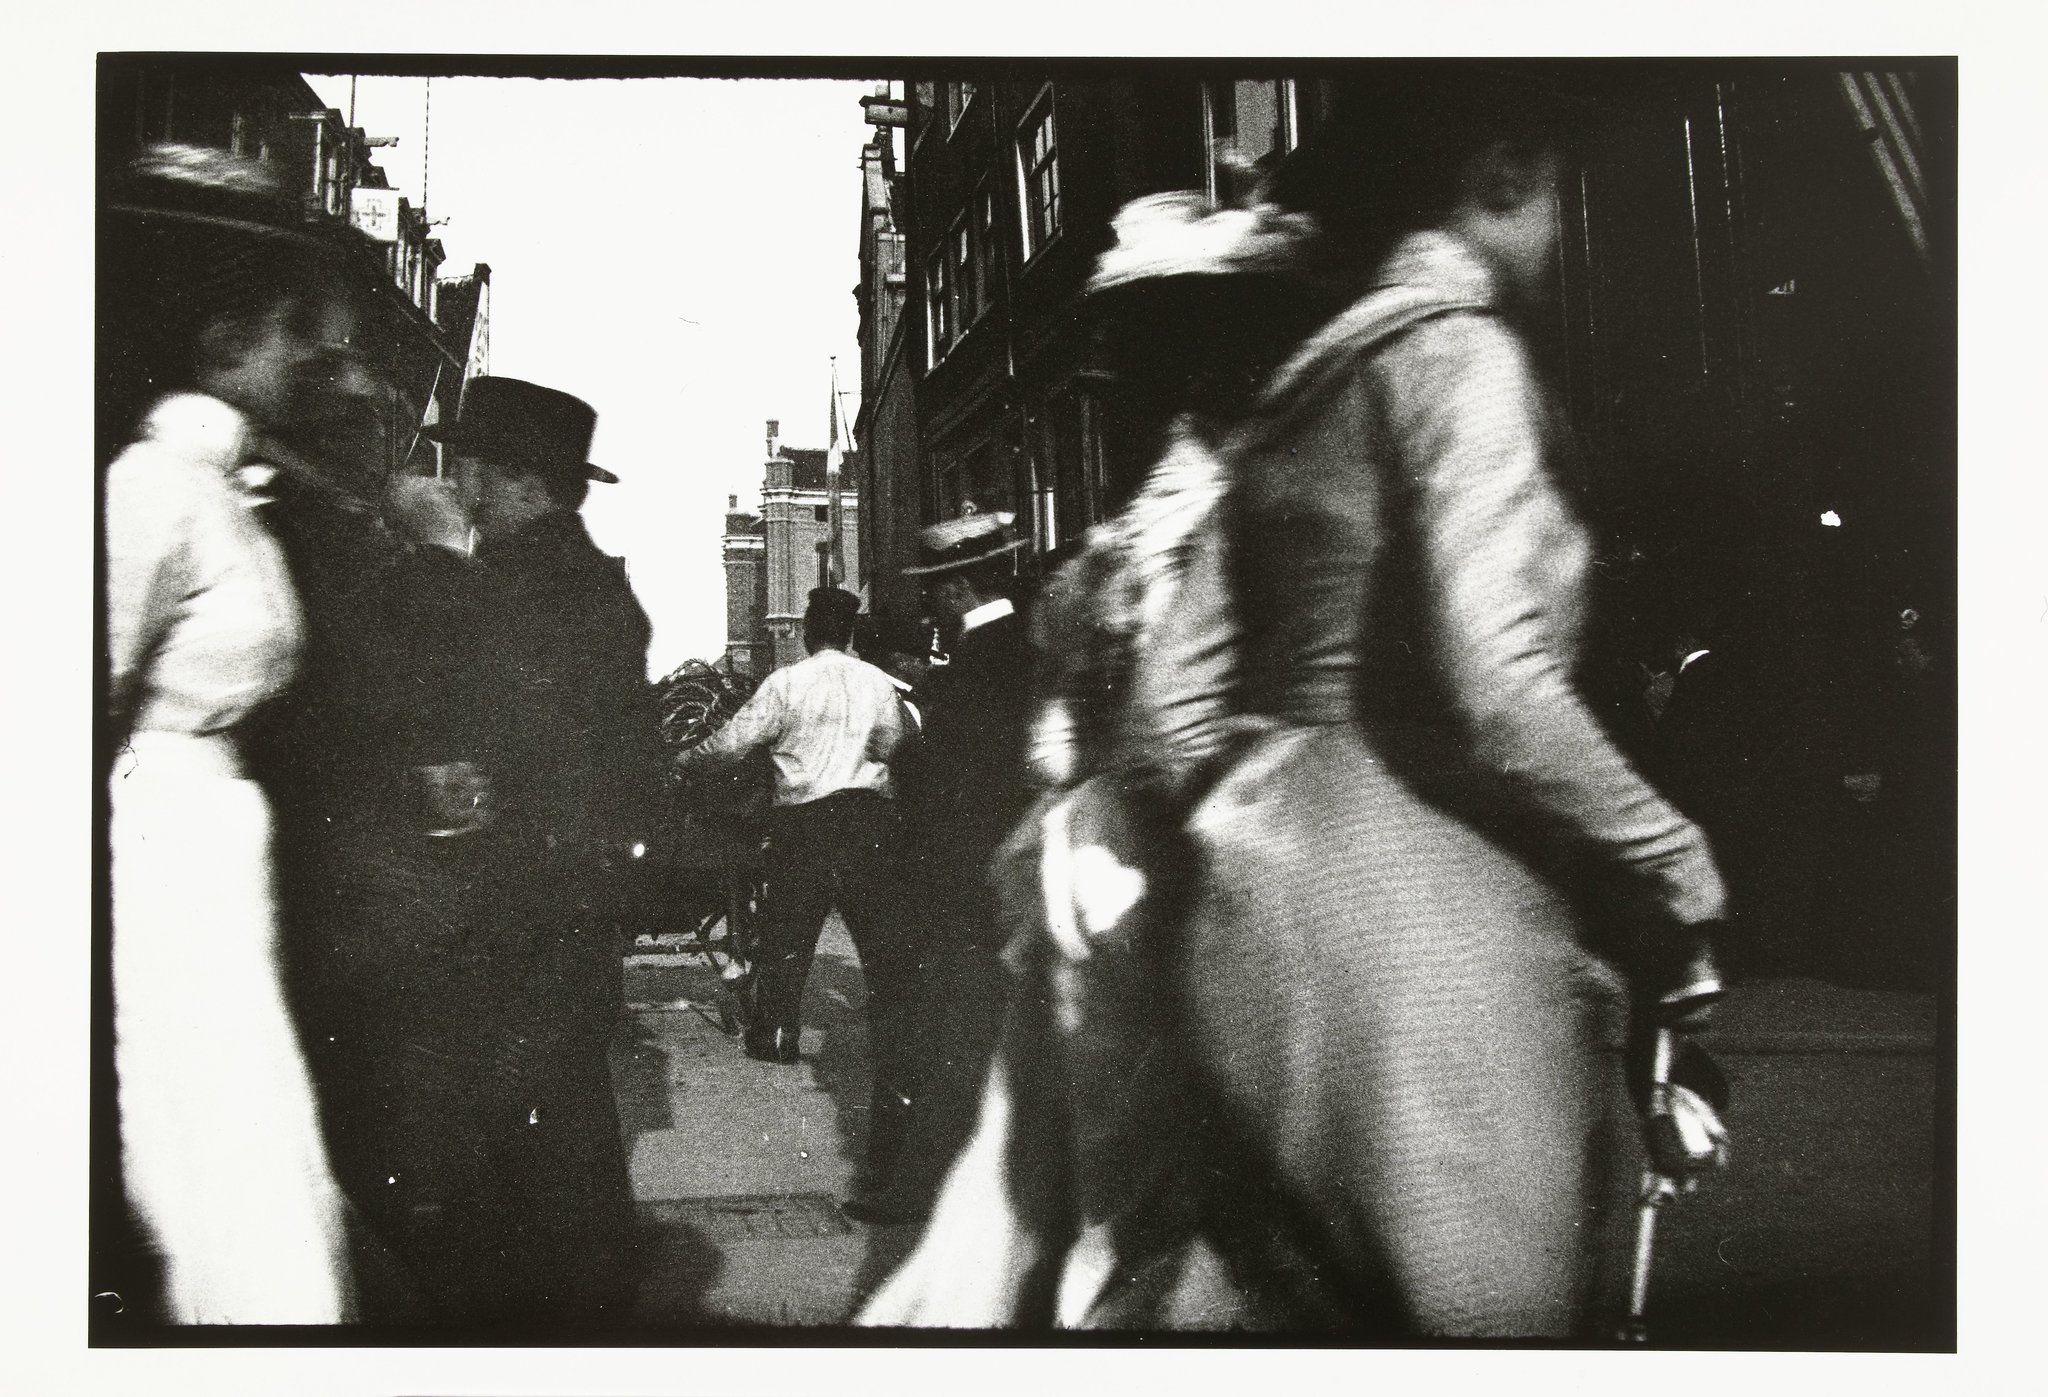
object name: photograph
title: Wandelaars op het Spui en de Kalverstraat in Amsterdam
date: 1890-1910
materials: paper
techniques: gelatin silver print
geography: amsterdam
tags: kalverstraat, spui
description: Moderne afdruk van negatief BR 1166 (collectie RKD).